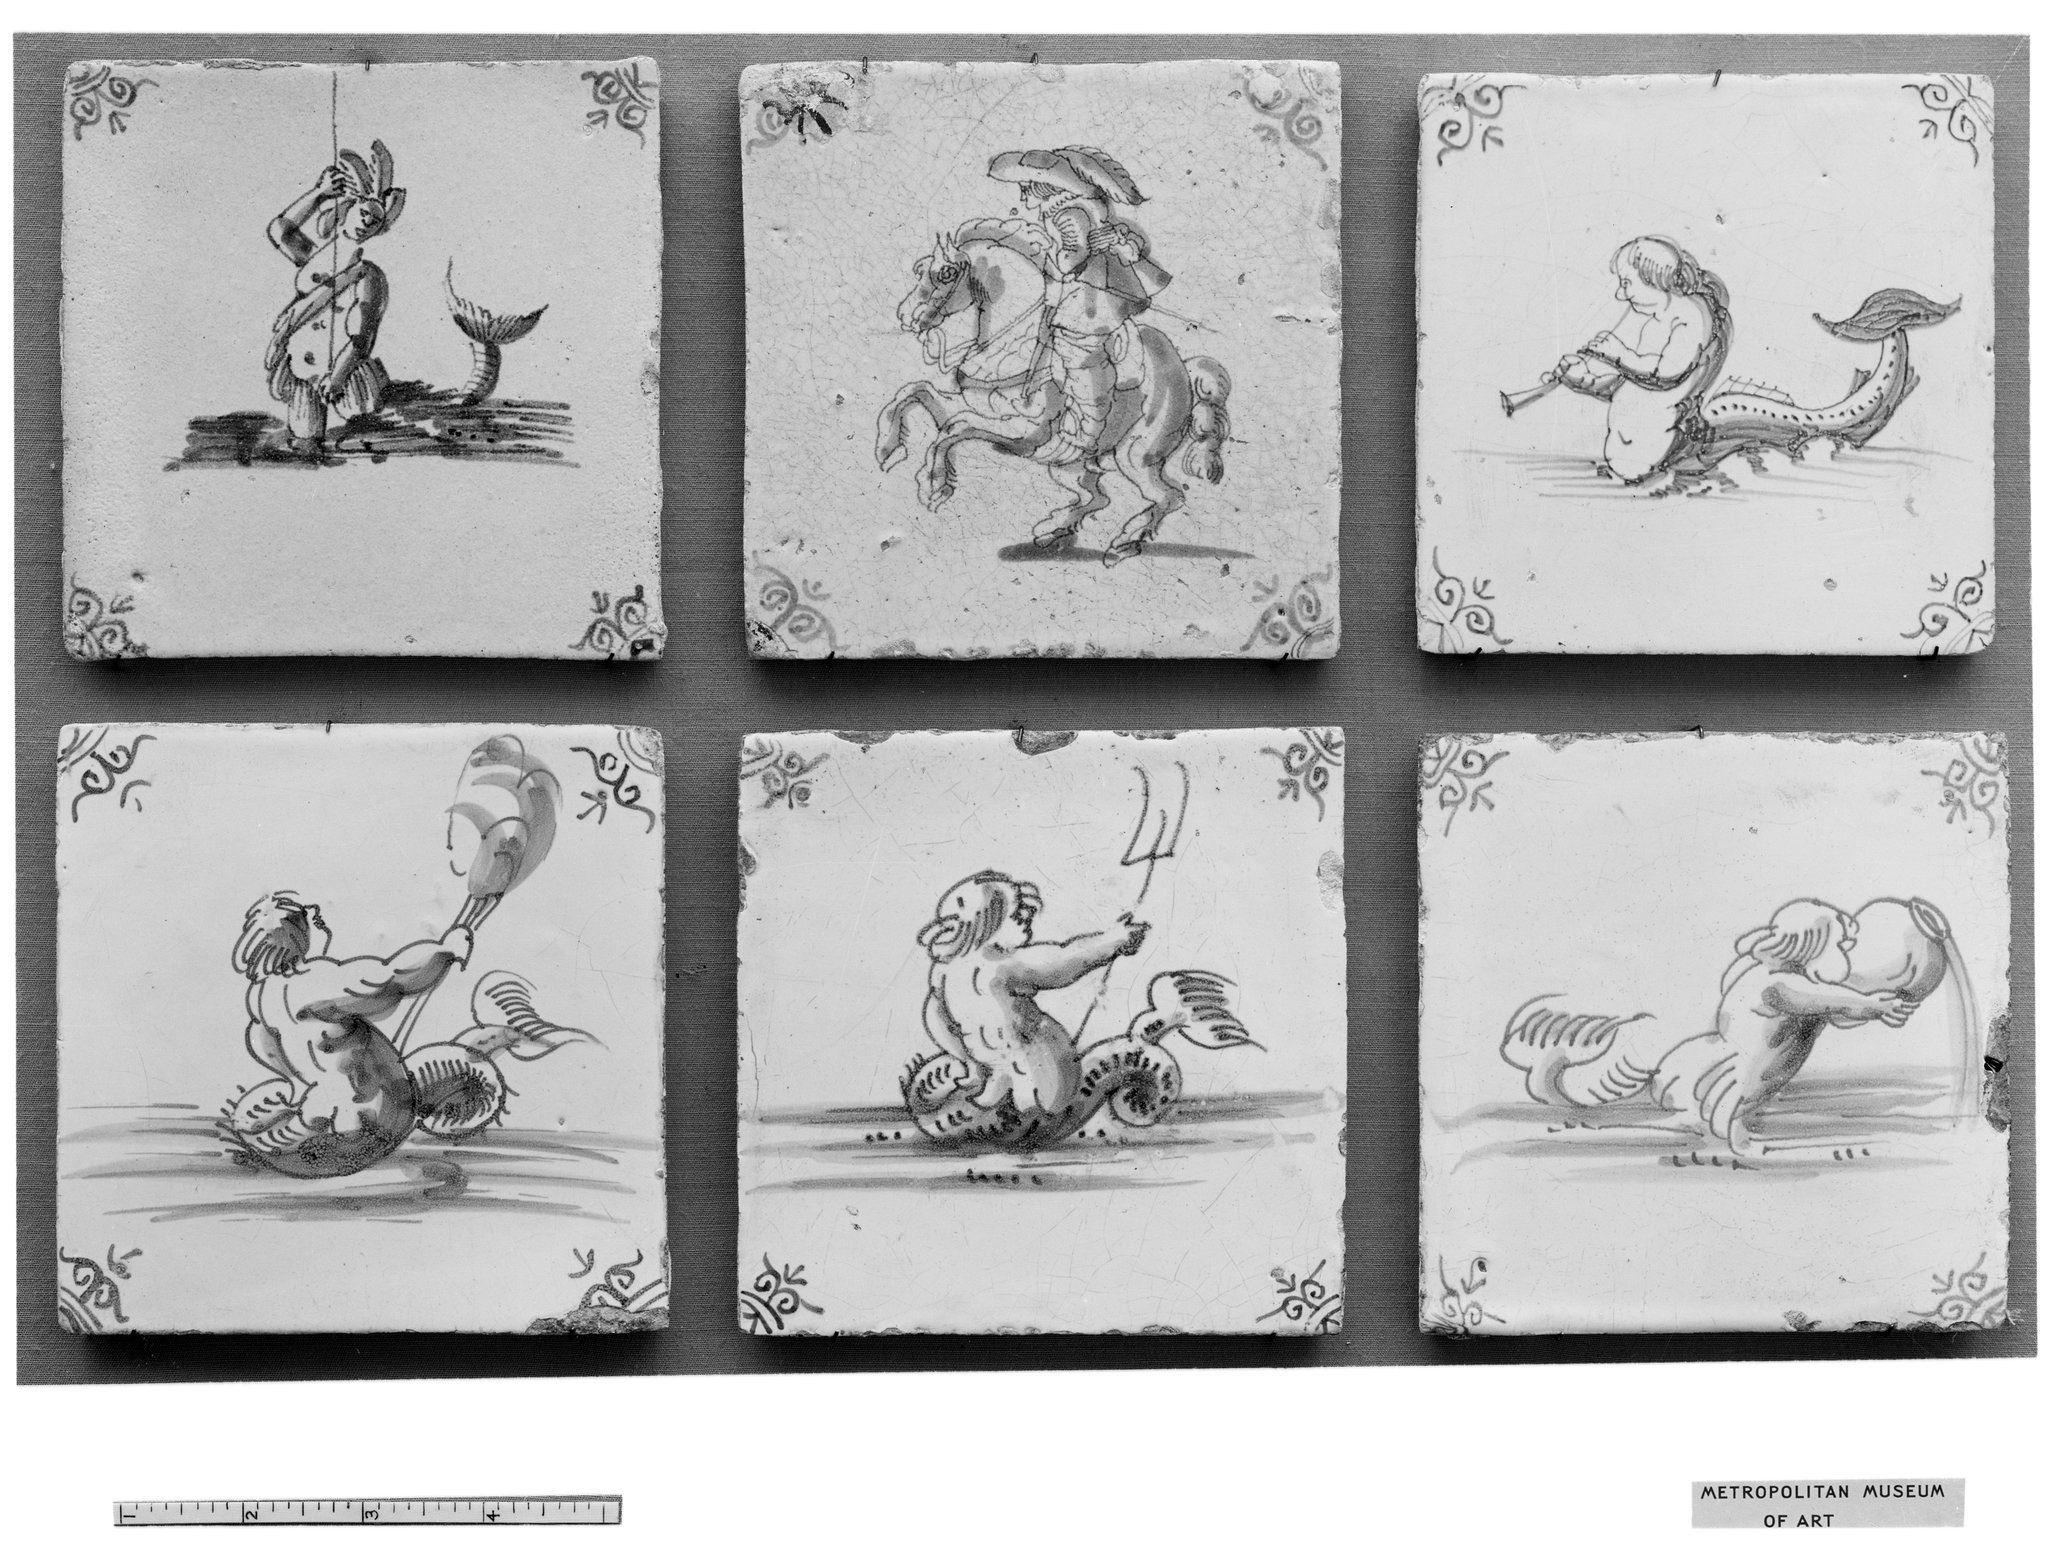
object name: tile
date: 1640-1660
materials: earthenware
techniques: glazing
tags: men,mermaids,horses